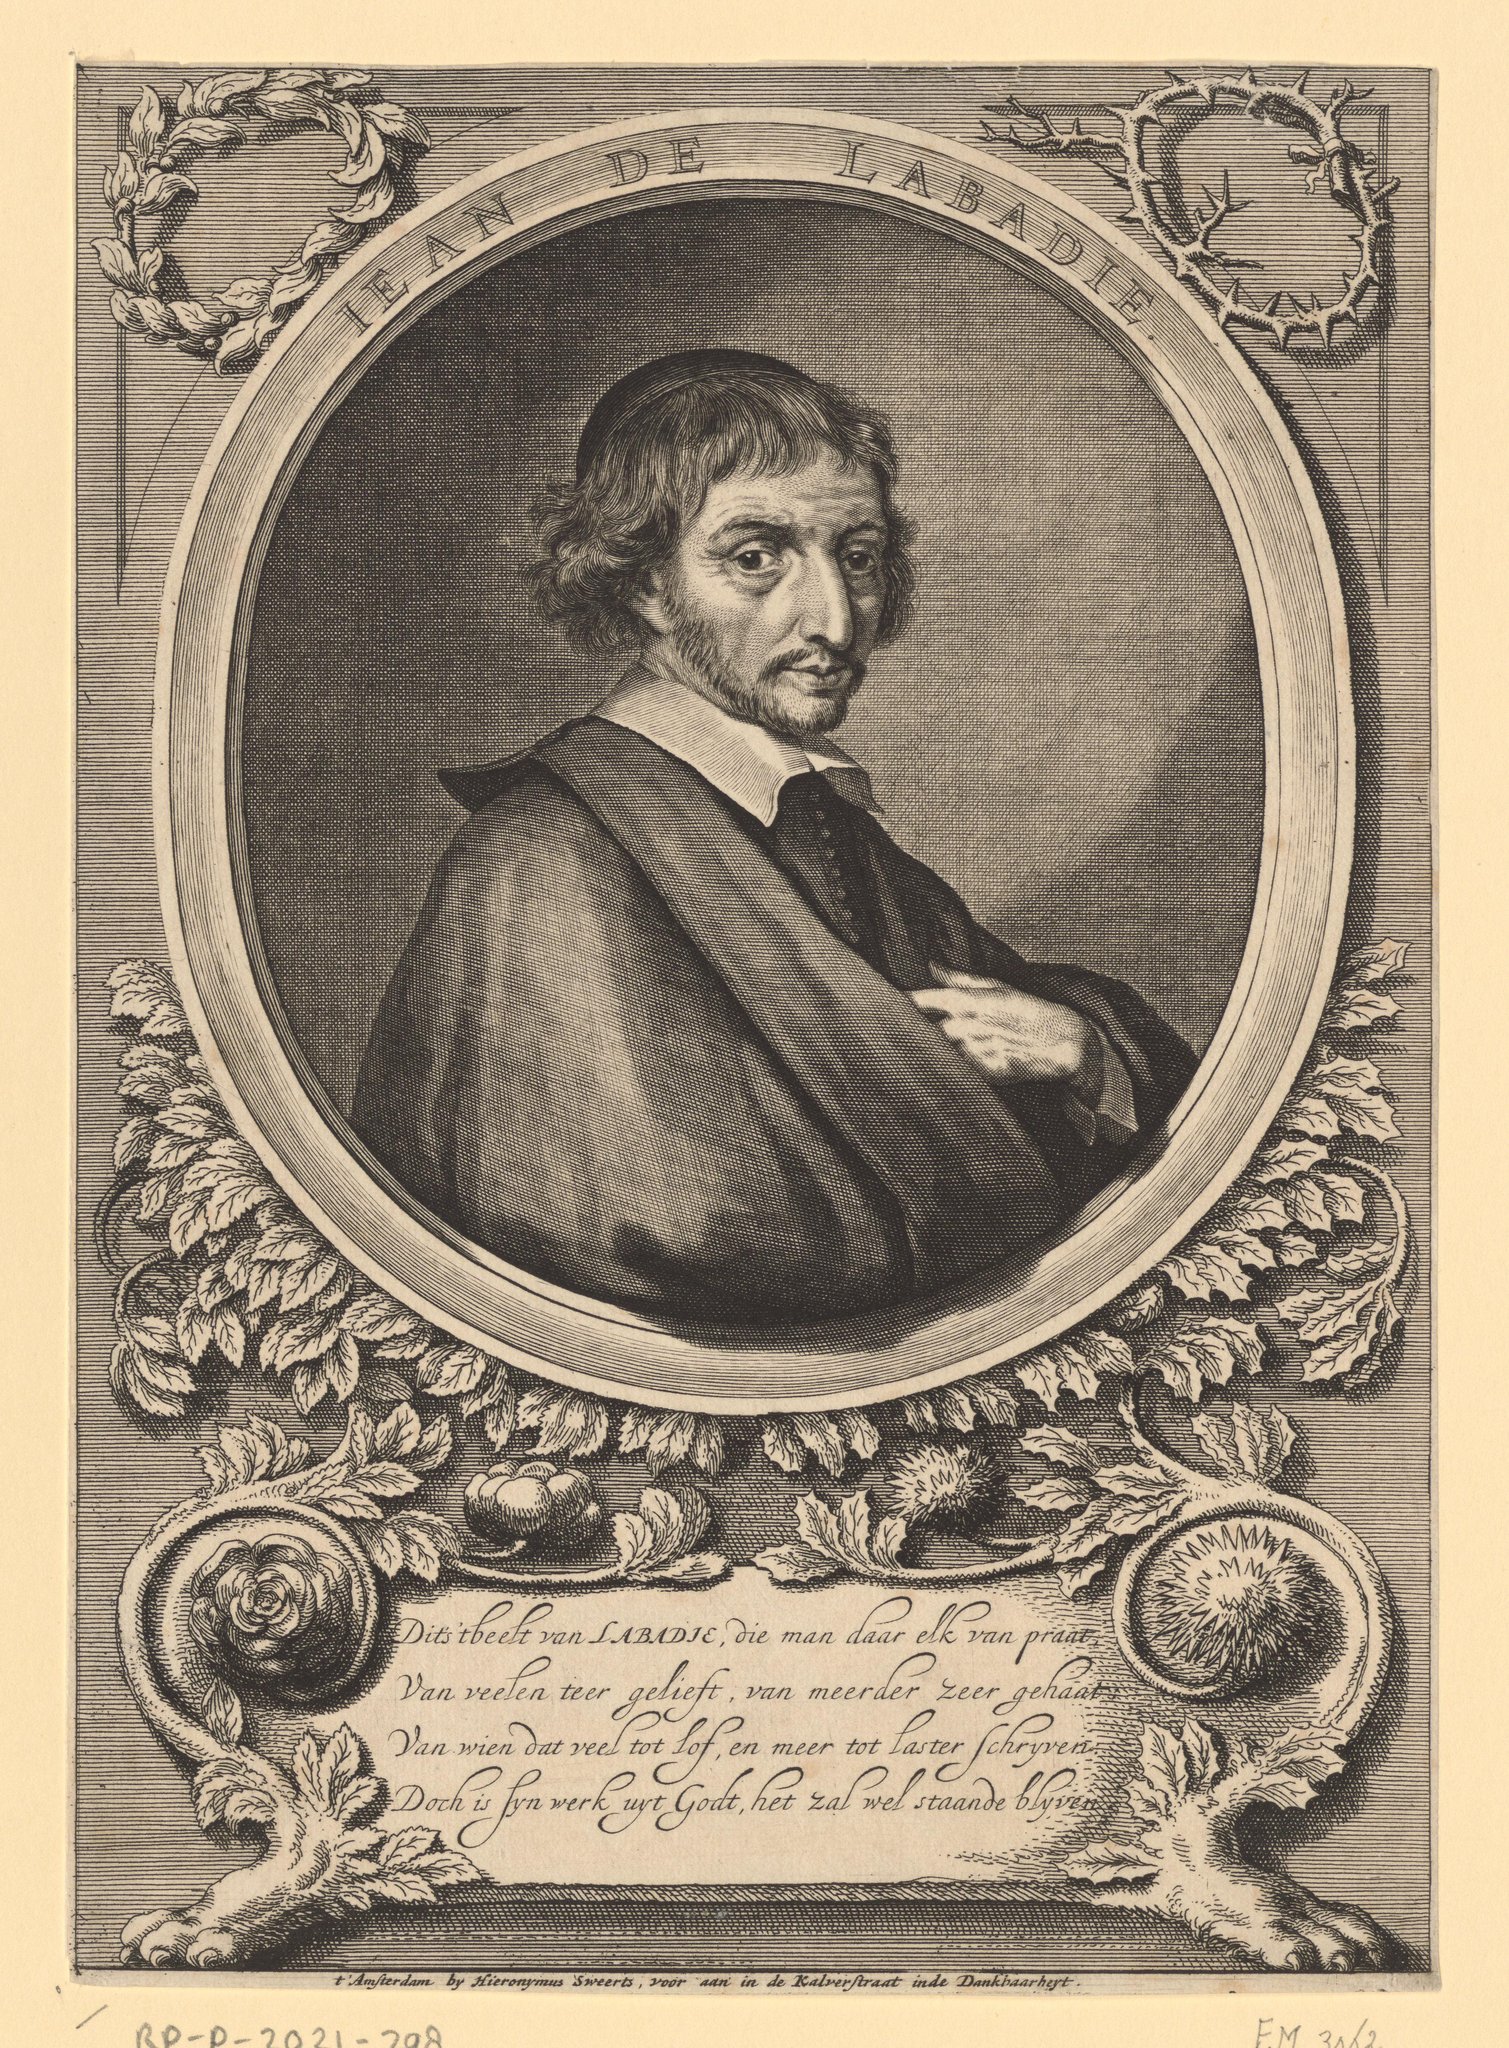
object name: print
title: Portret van Jean de Labadie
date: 1665-1696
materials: paper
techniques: engraving, etching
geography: amsterdam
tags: historical persons, crown of thorns ~ instruments of the passion, flowers: rose, plants and herbs: thistle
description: Rond het portret een ornamentele omlijsting met in de linkerbovenhoek een lauwerkrans en in de rechterbovenhoek een doornenkroon. Linksonder een roos en rechtsonder een distel met daartussen een cartouche met vierregelig vers in het Nederlands.